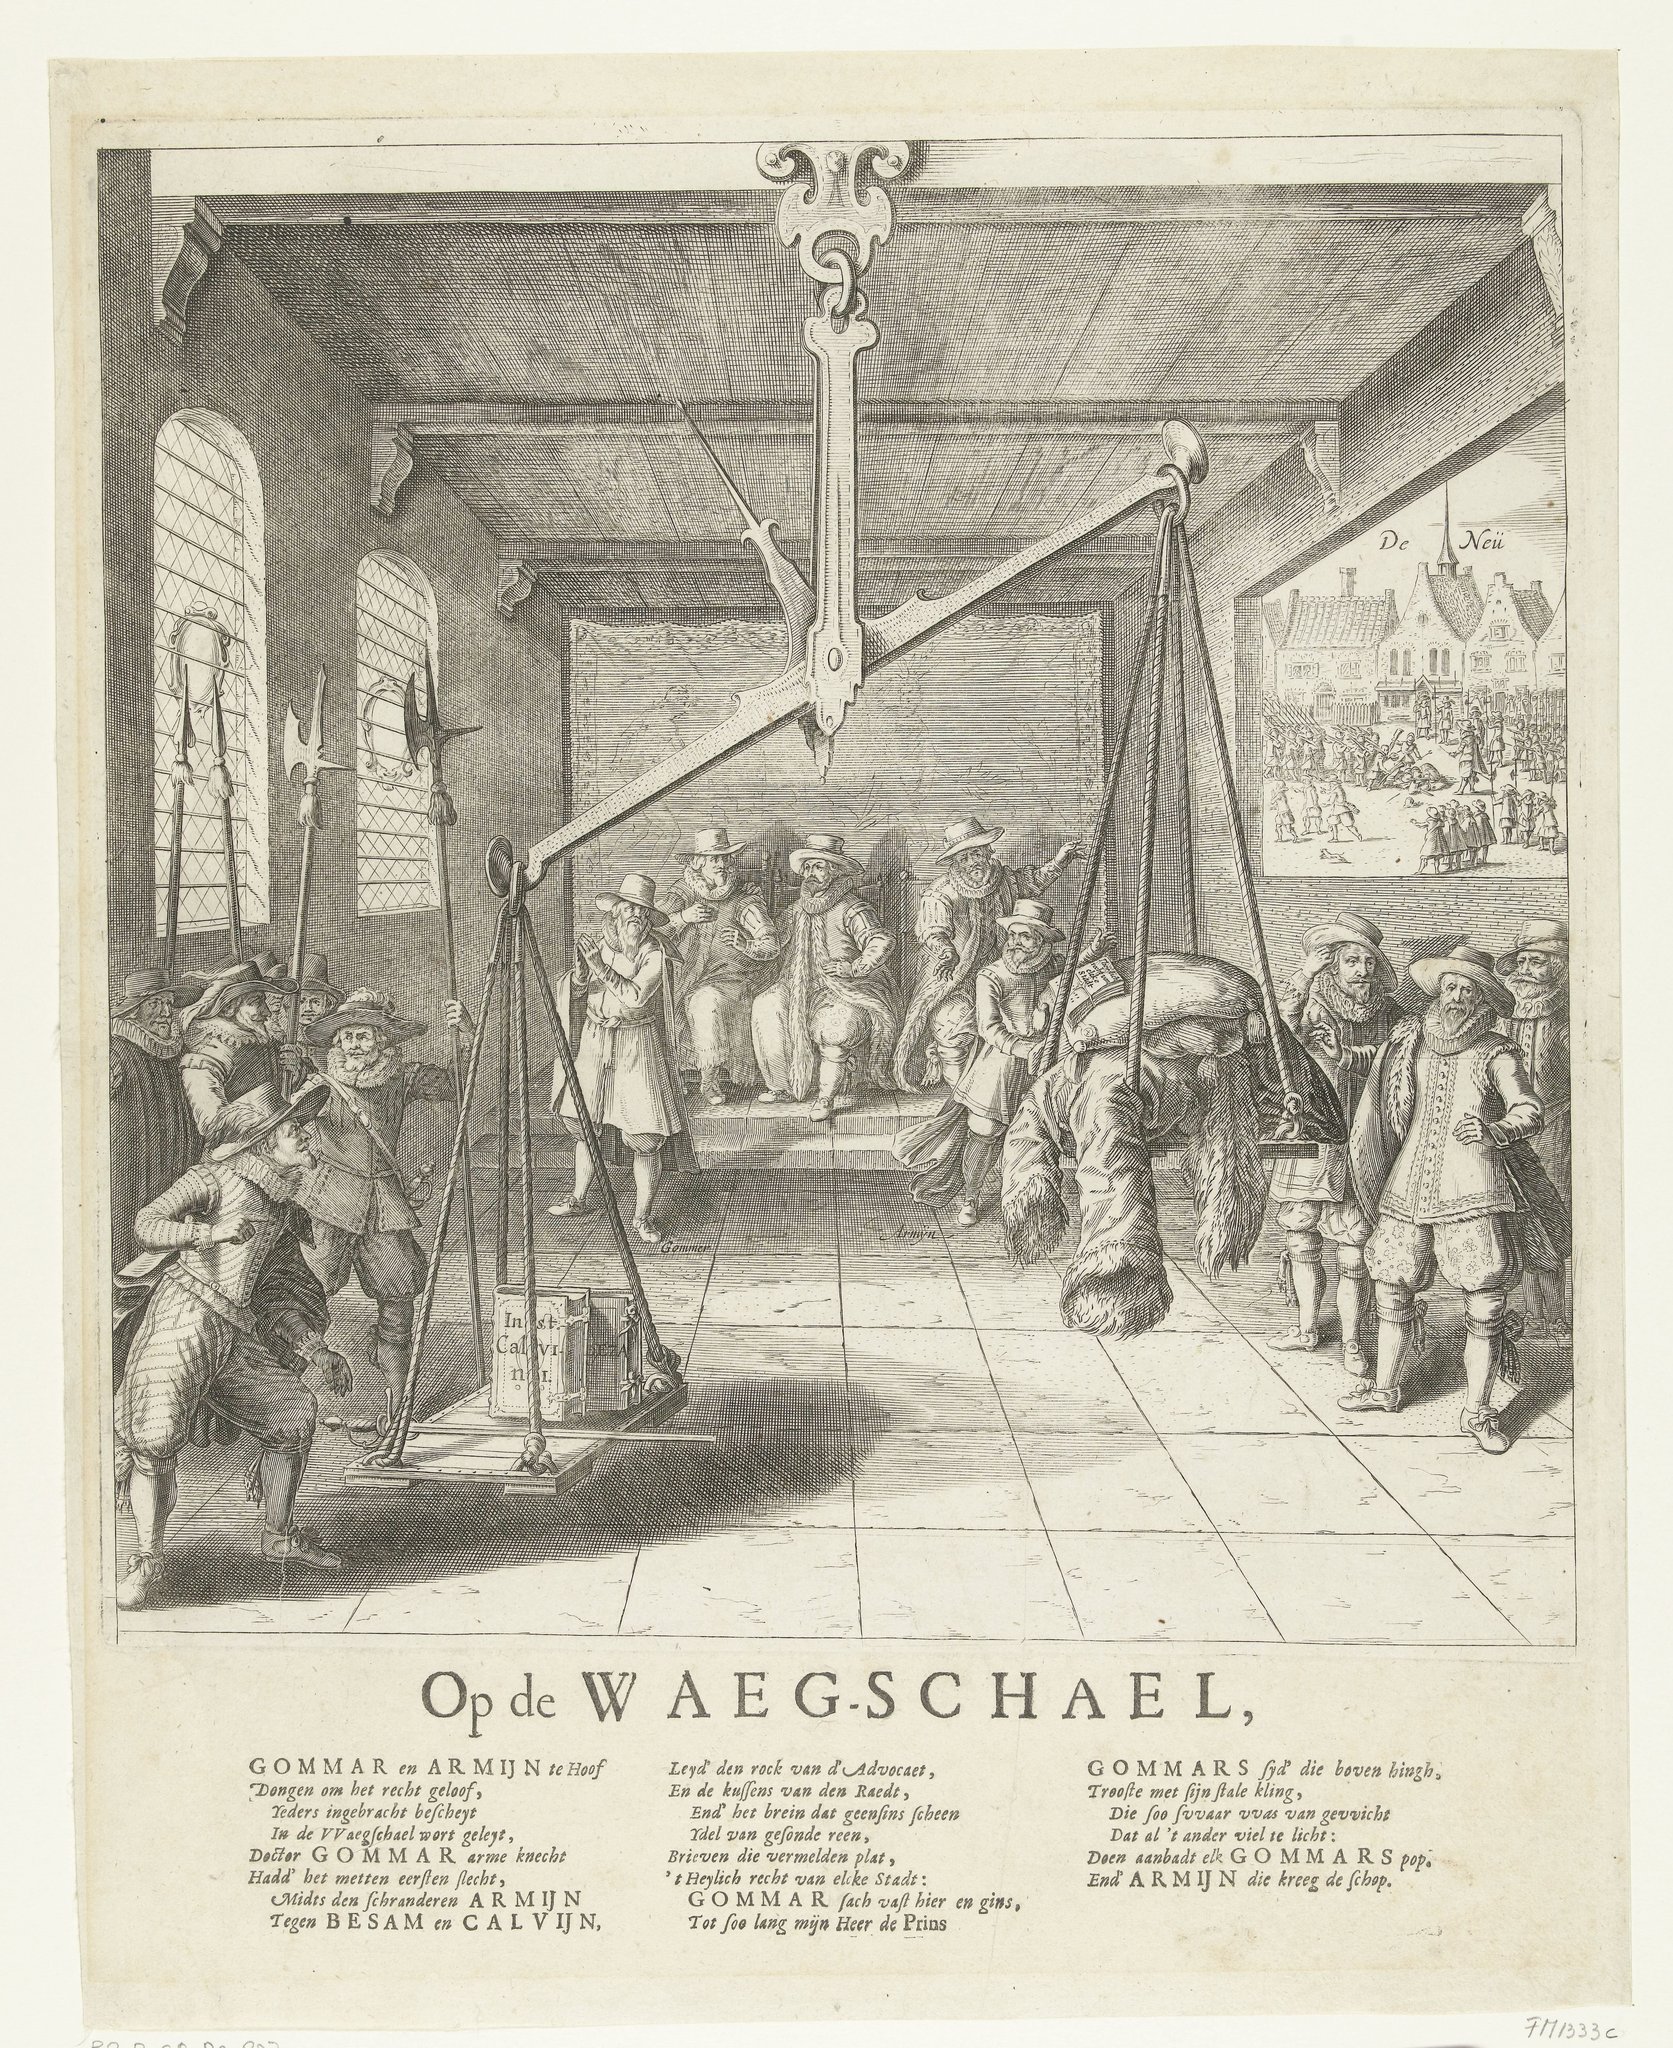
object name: print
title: Op de Waeg-Schael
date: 1618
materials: paper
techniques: engraving, letterpress printing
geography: northern netherlands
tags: the hague, johan van oldenbarnevelt, maurice (prince of orange), bruges, scales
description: Politieke allegorie op de overwinning van de contraremonstranten dankzij het ingrijpen van prins Maurits, 1618. De voorstelling toont een interieur met een grote weegschaal. Hierop worden, in aanwezigheid van Gomarus, Arminius, Johan van Oldenbarnevelt en anderen, de argumenten van de contraremonstranten en de remonstranten tegen elkaar afgewogen. Maurits doet de balans ten gunste van de contraremonstranten doorslaan door zijn zwaard op de weegschaal te leggen. Op de achtergrond door een venster de afdanking van de waardgelders door Maurits op de Neude te Utrecht. Onder de voorstelling in drie kolommen een vers van Vondel.